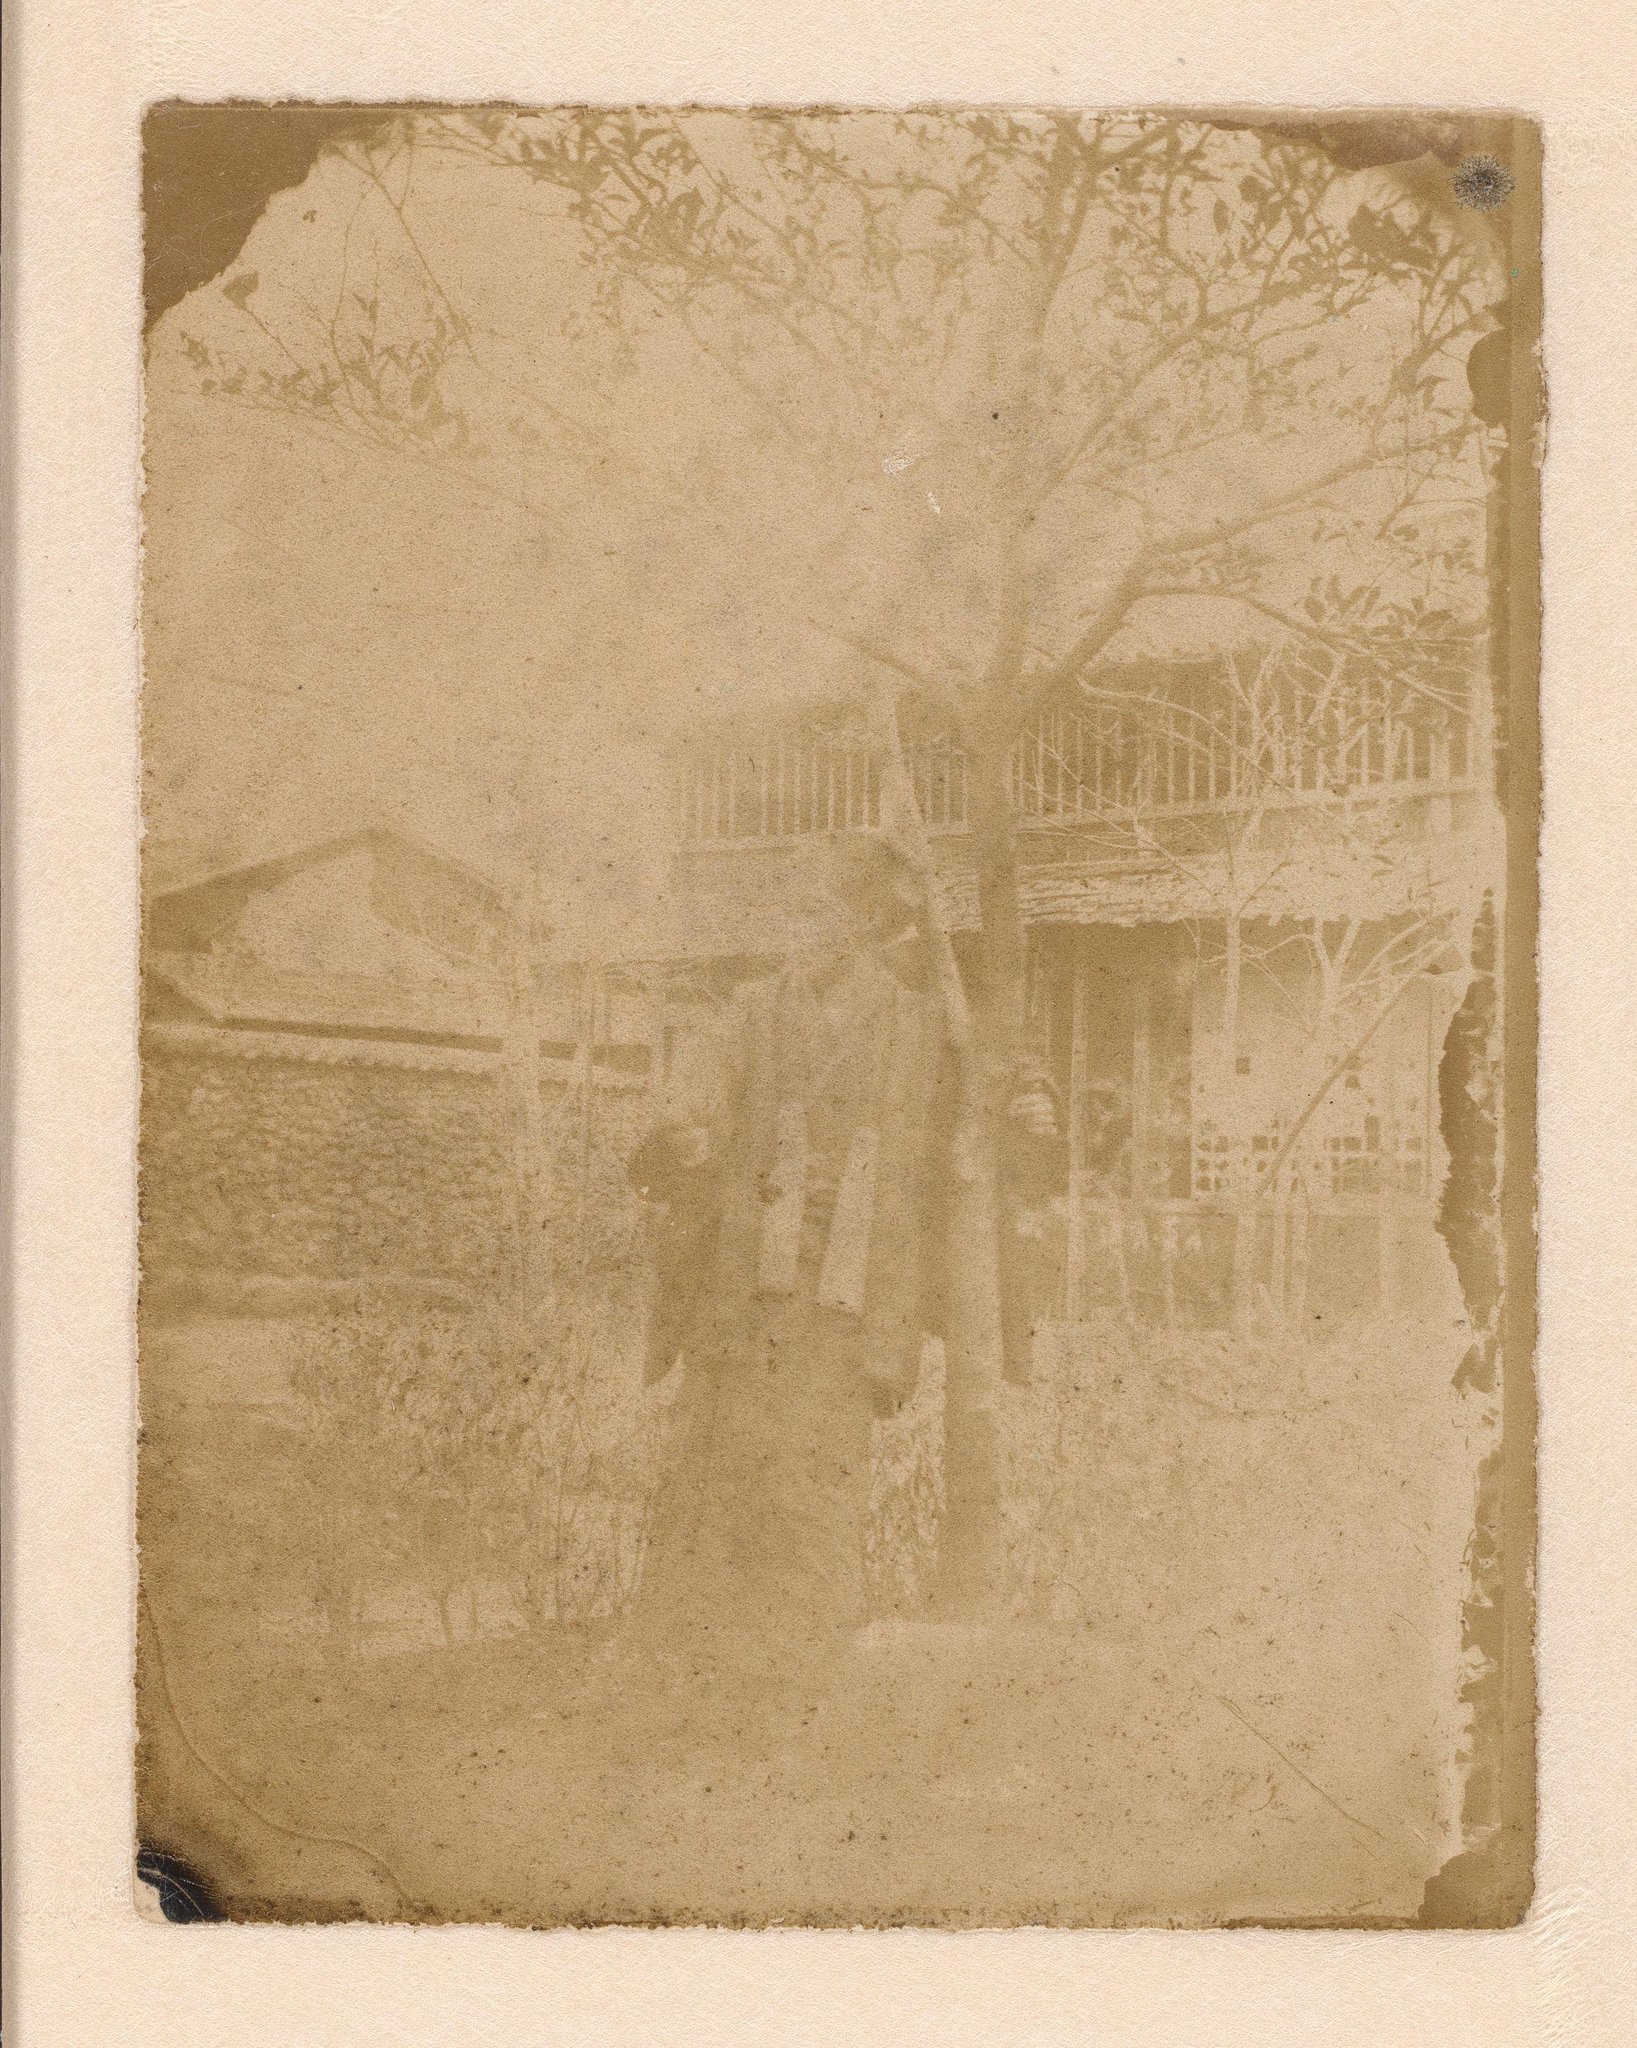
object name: photograph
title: Japanse vrouw staand bij boom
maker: antoon bauduin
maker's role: amateurfotograaf, hoogleraar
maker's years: 1820-1885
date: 1862-1866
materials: paper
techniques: albumen print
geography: japan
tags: trees, japanese, japan